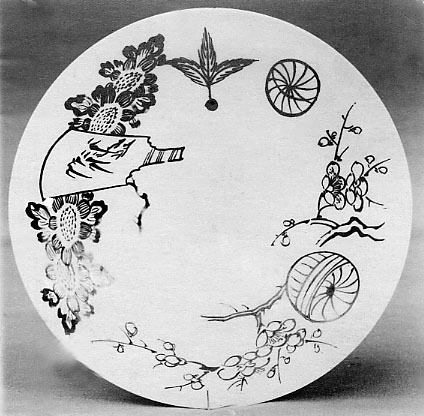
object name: saucer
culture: japanese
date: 1801-1900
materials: porcelain